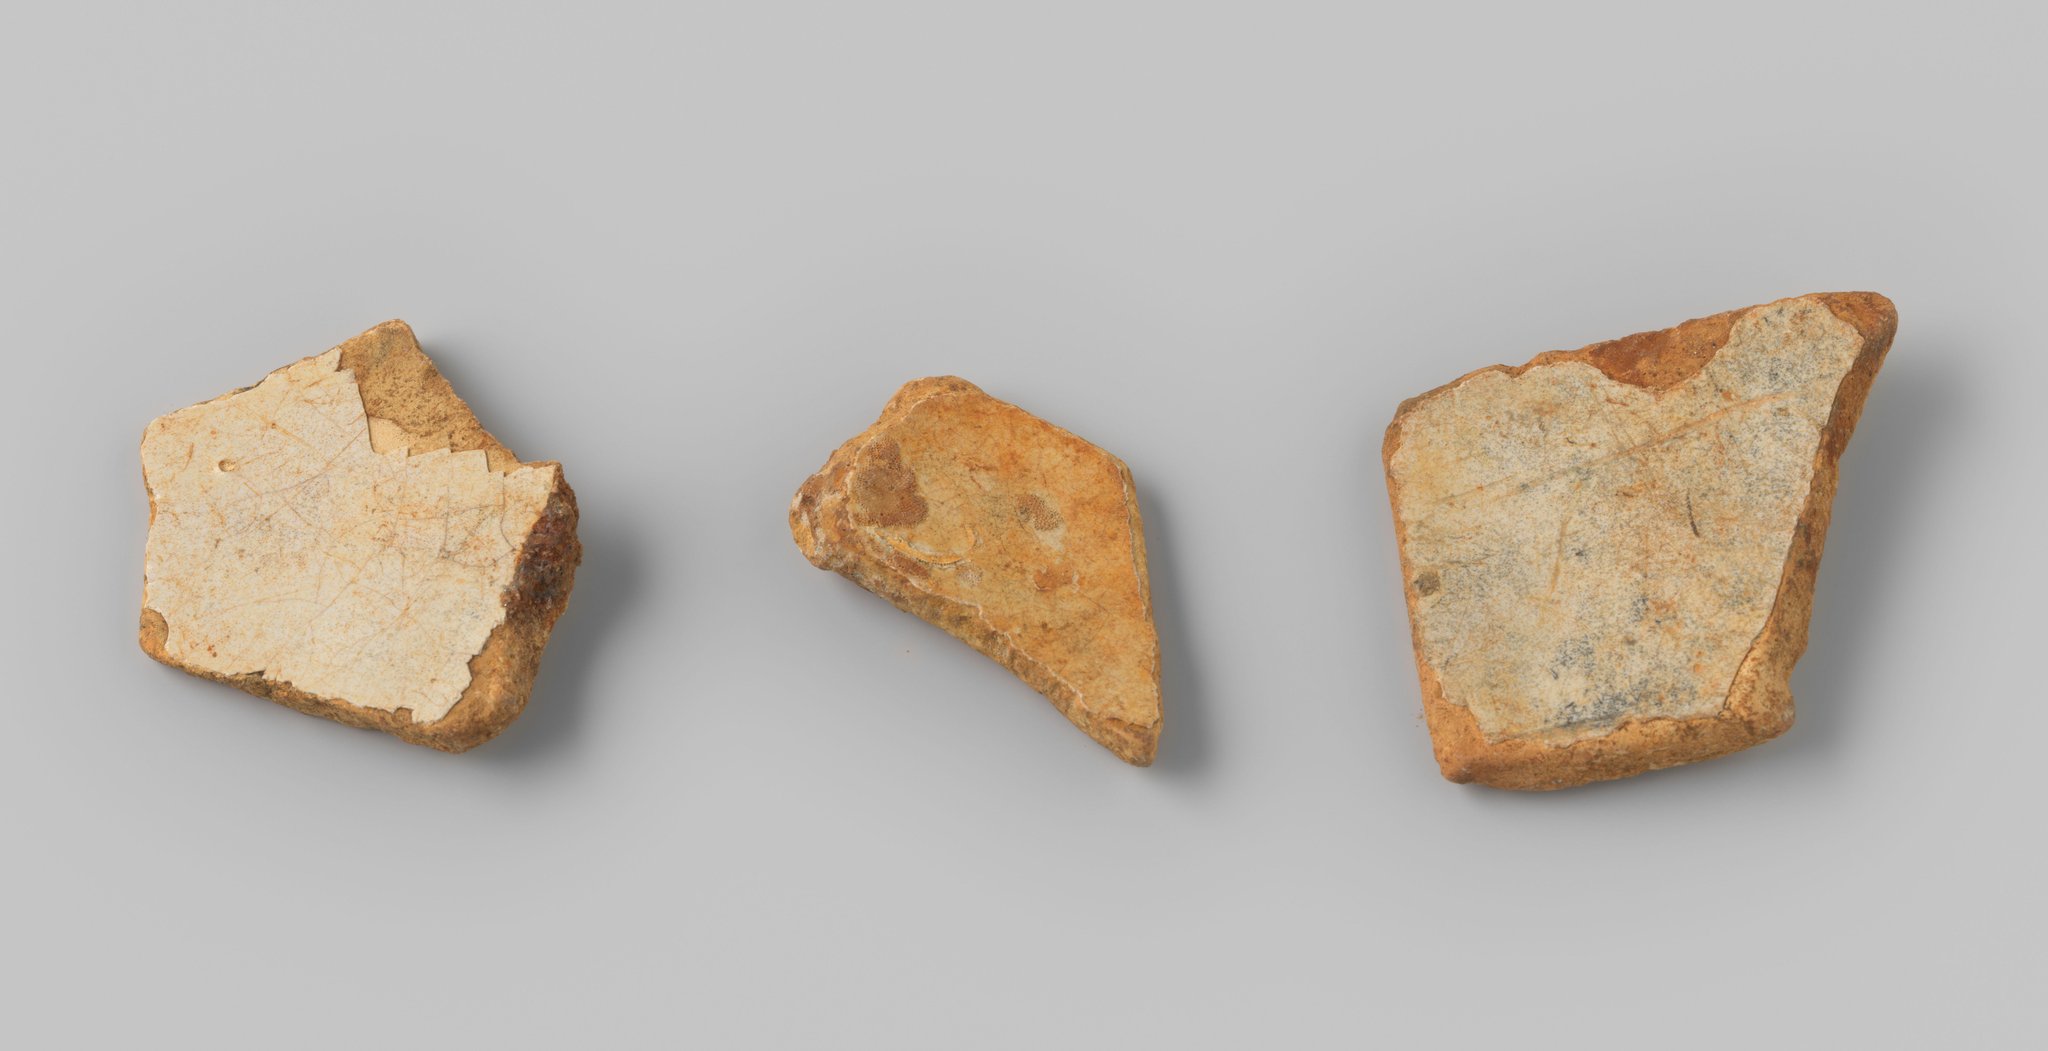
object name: sherd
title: Scherven van borden uit het wrak van de Oost-Indiëvaarder Hollandia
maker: Anonymous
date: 1700-1743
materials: faience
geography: netherlands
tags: verenigde oostindische compagnie, hollandia (schip), annet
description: Faience (tin-glazed) plate; fragm of centre, sim. NG 1980-27H449.